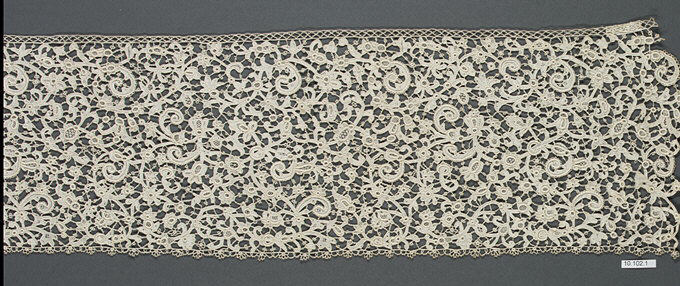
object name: fragment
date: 1801-1900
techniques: lace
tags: flowers,leaves